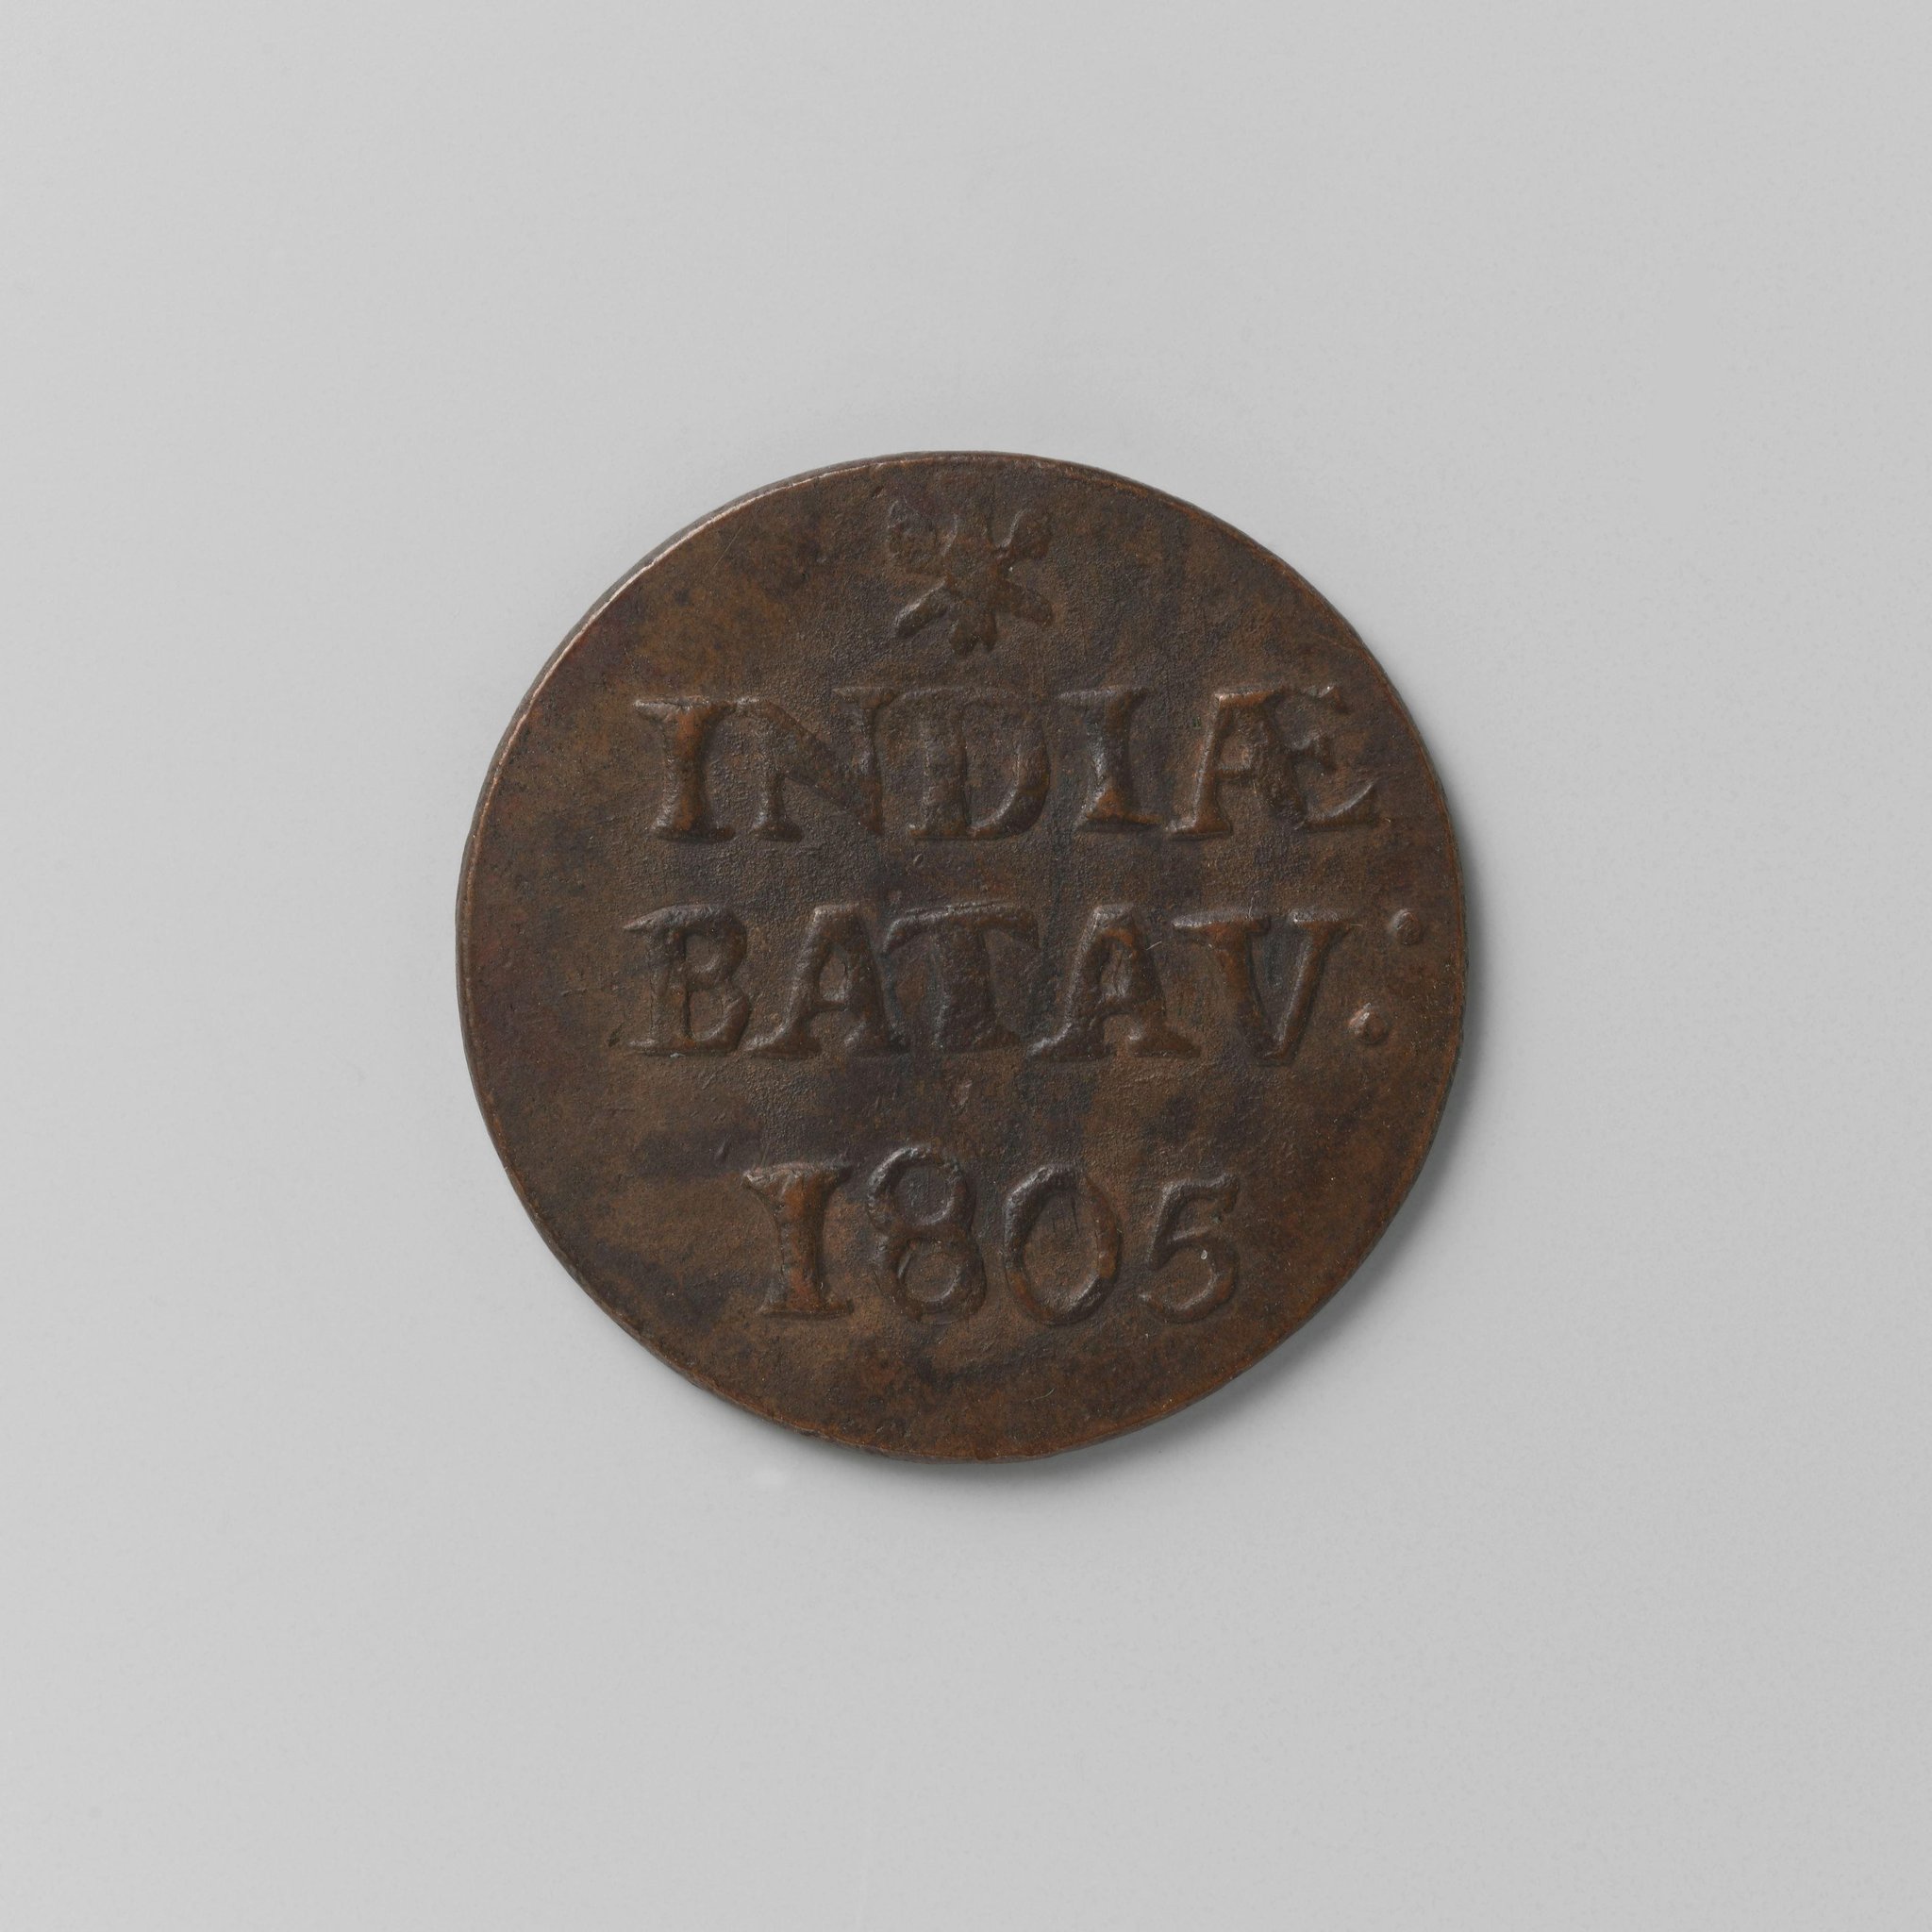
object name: coin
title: Duit voor Nederlands Indië uit Overijssel,1805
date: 1805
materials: copper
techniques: striking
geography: kampen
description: Koperen munt. Voorzijde: tweeregelig opschrift, waarboven muntmeesterteken en waaronder jaartal. Keerzijde: binnen wapenspreuk tussen waarde-aanduiding 5 1/16 G gekroond wapenschild van Overijssel. Gladde rand.